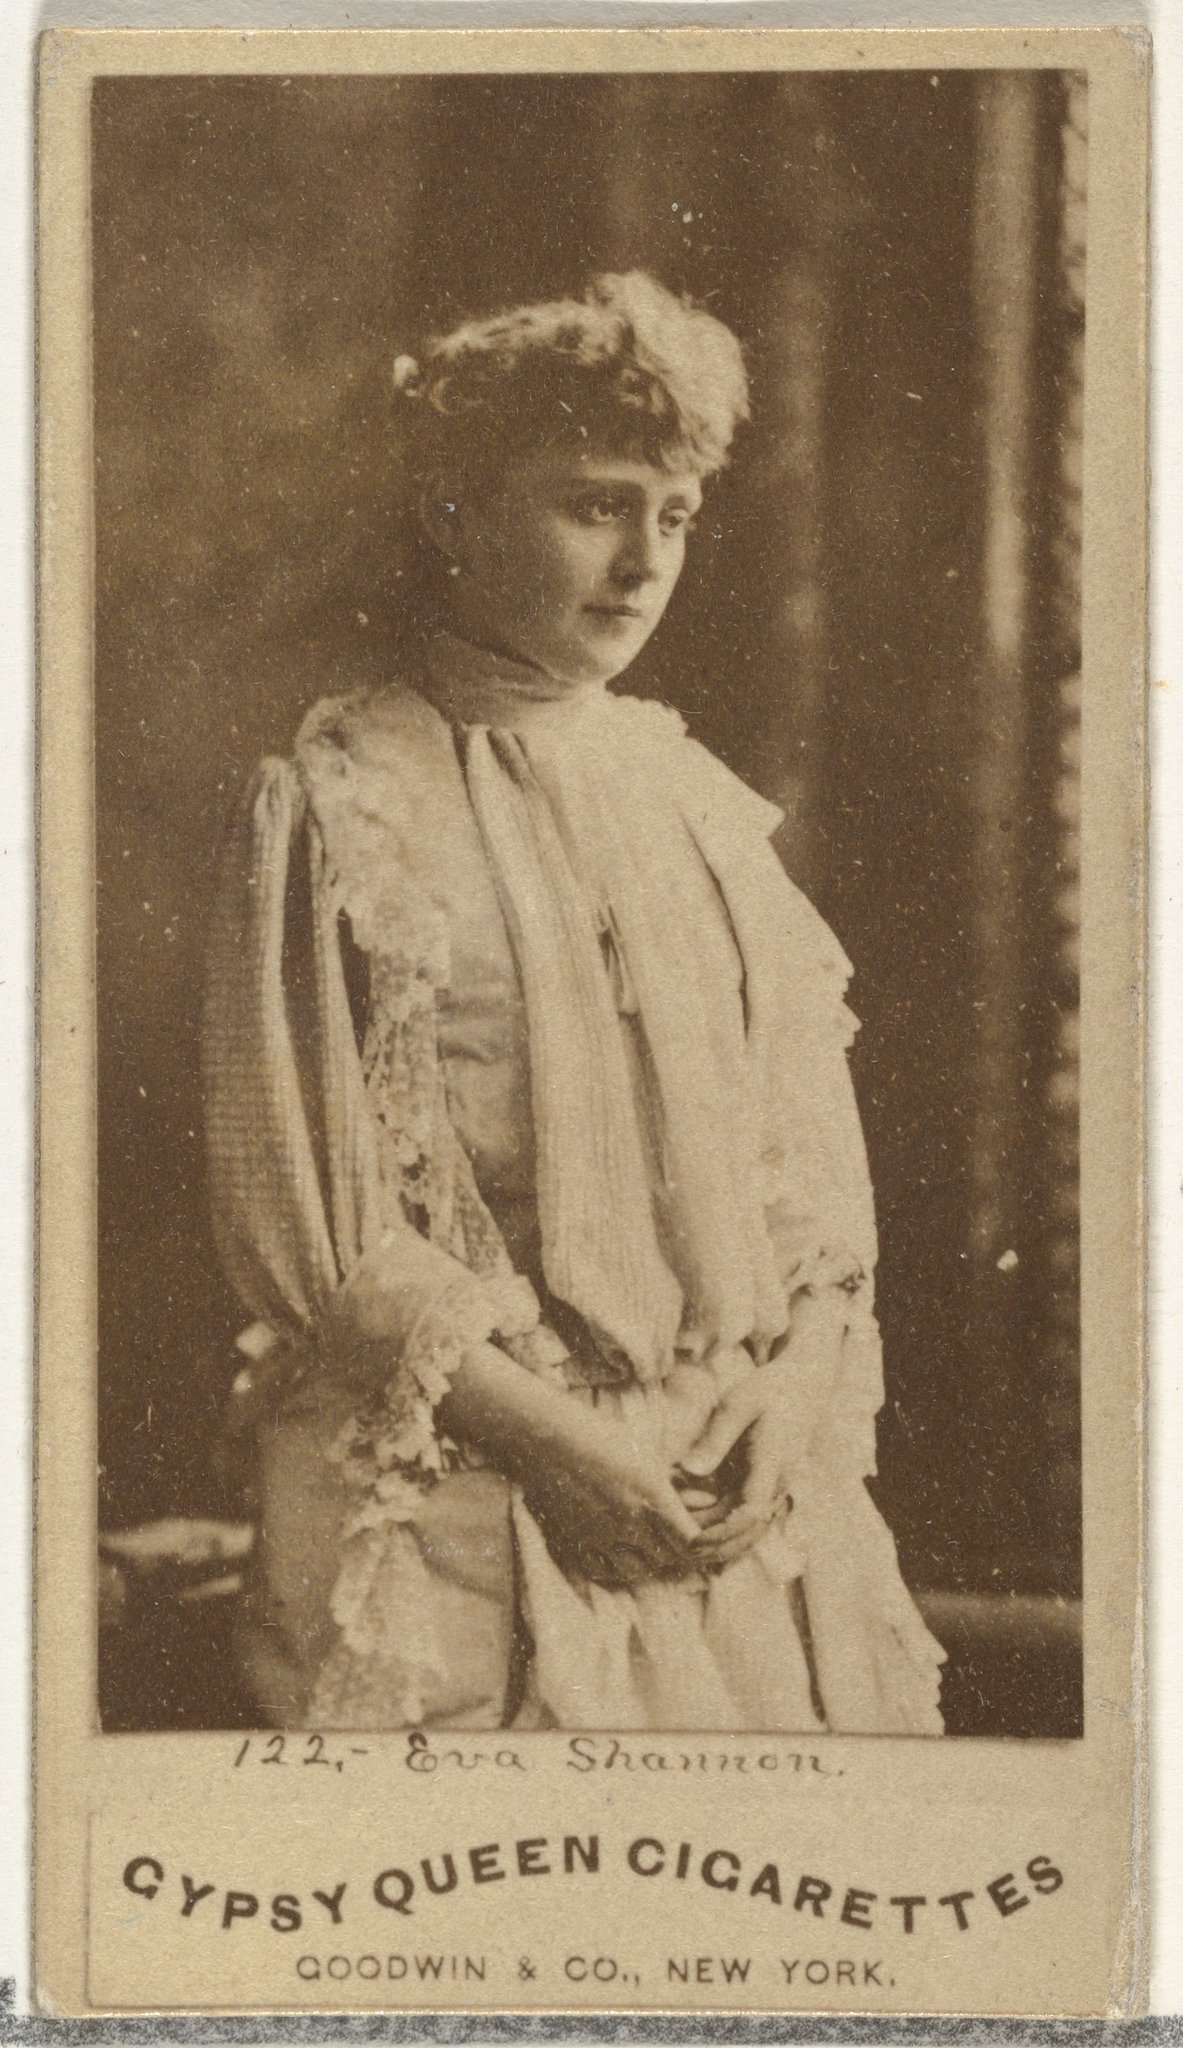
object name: photograph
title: Eva Shannon, from the Actors and Actresses series (N171) for Gypsy Queen Cigarettes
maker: goodwin & company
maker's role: publisher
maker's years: 1850-1950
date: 1886-1890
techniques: albumen silver print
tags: portraits,women,actresses